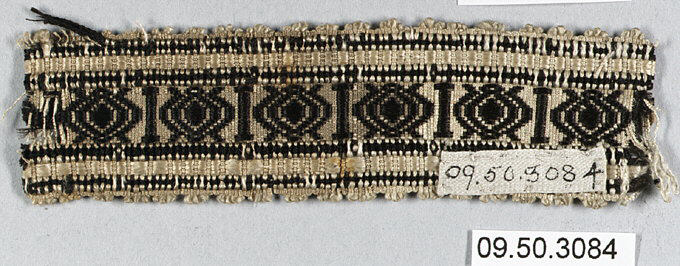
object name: gimp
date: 1701-1900